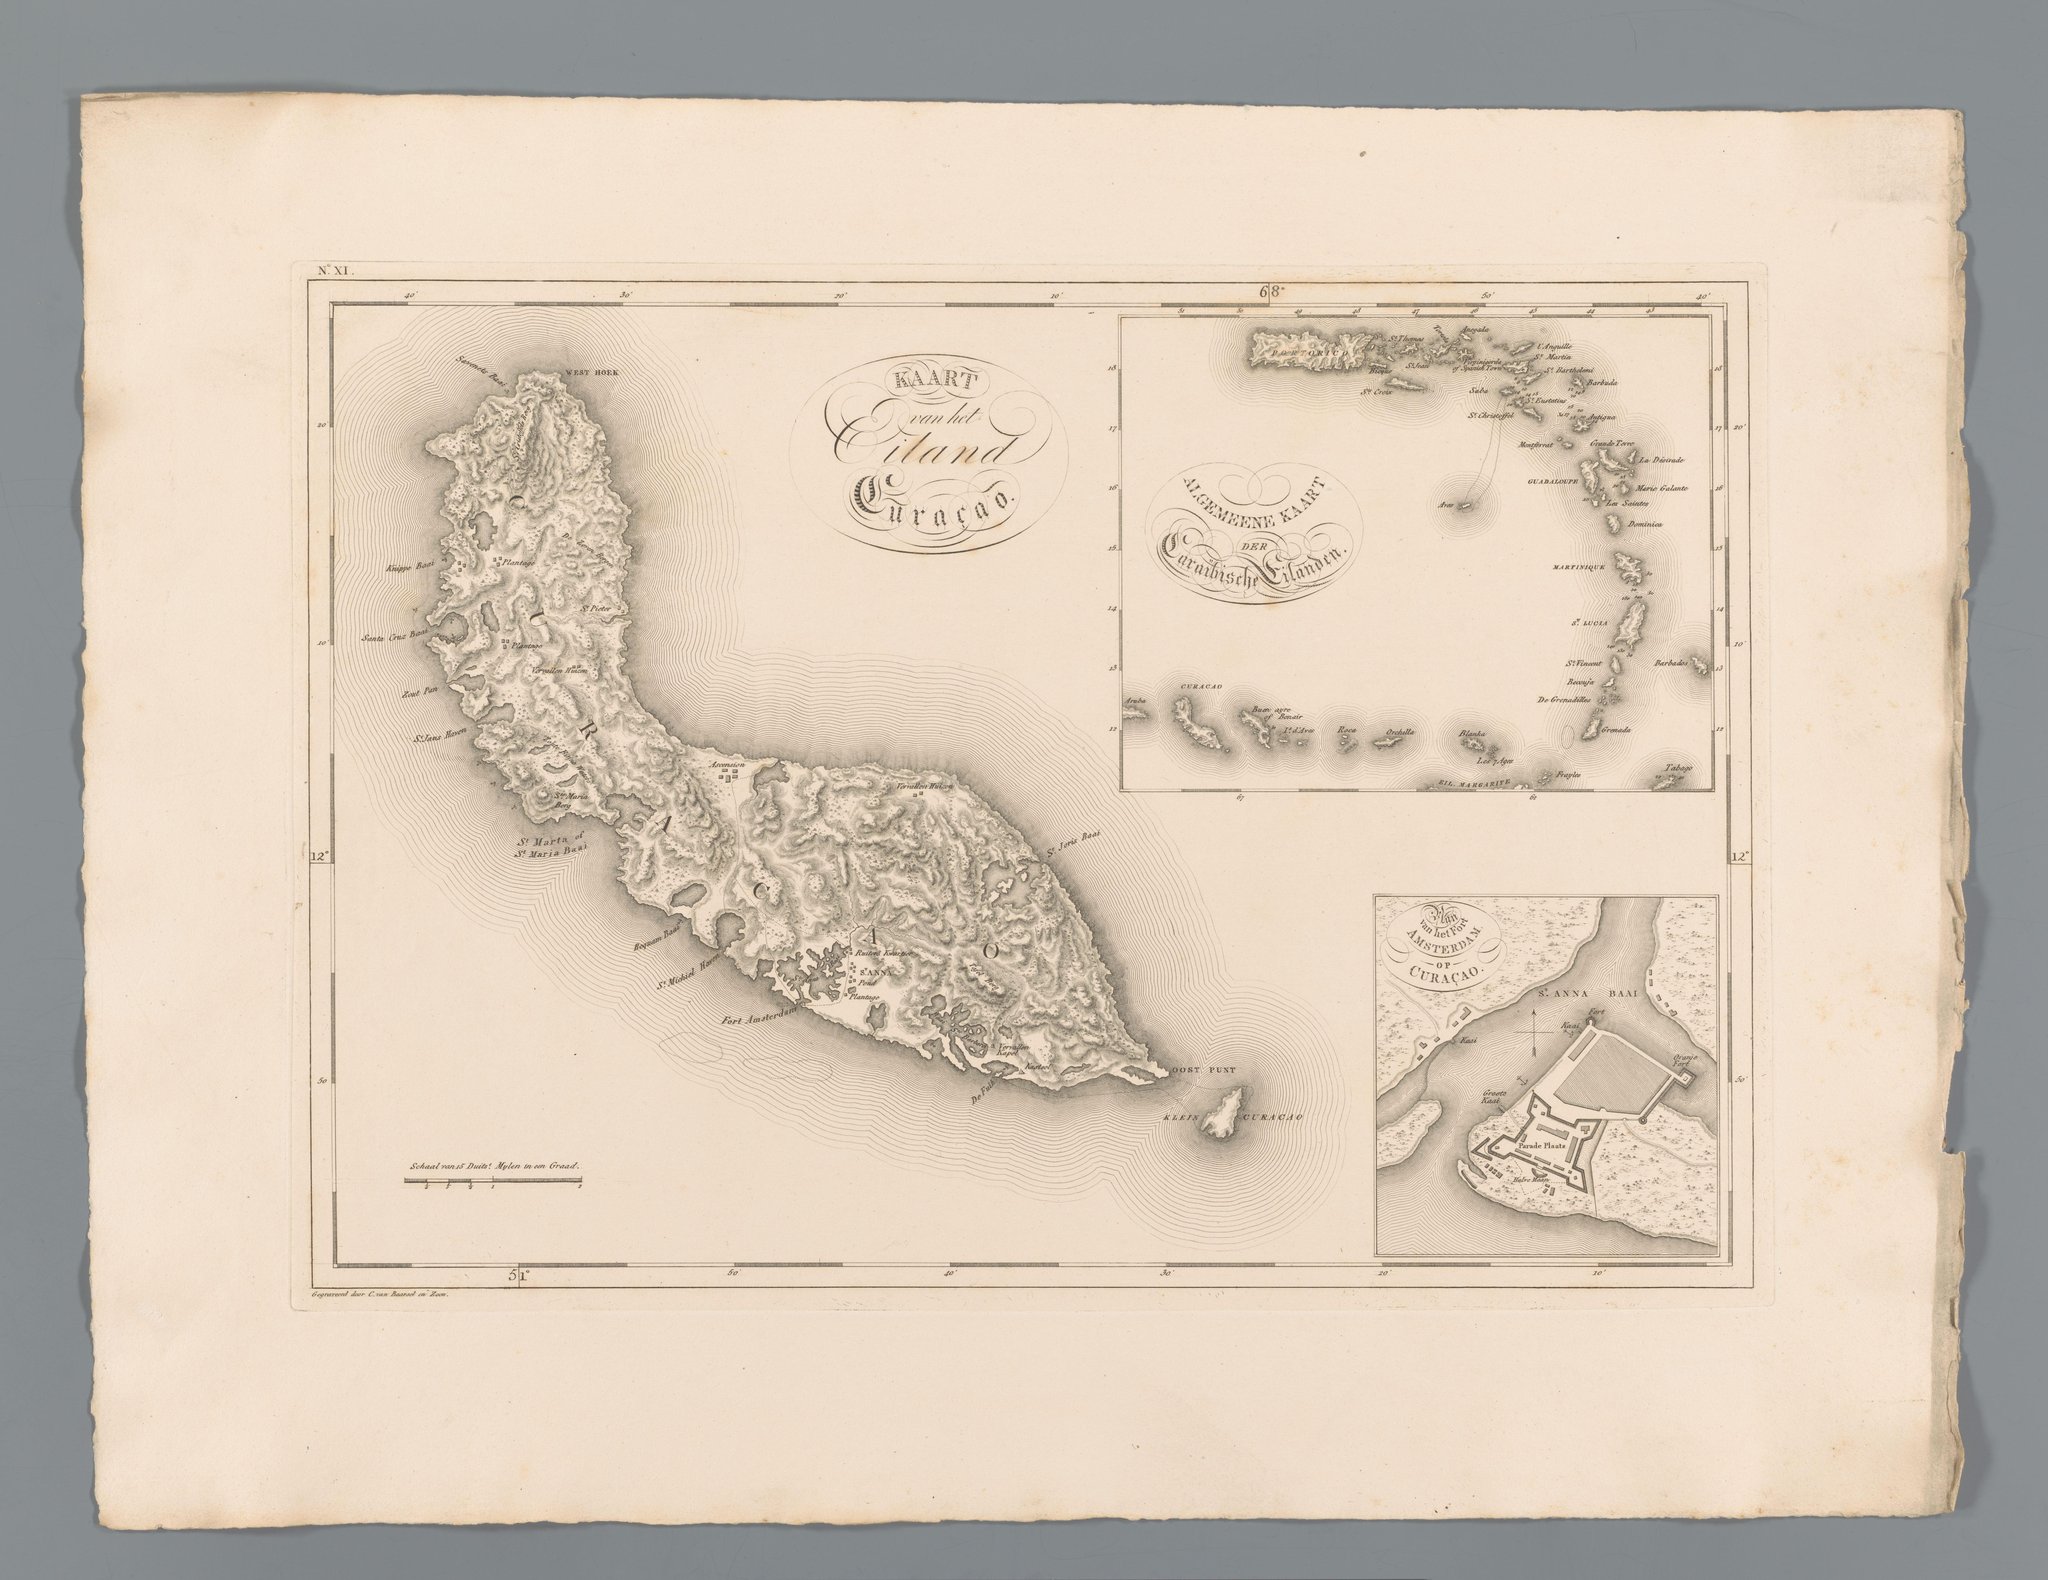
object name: print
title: Plan van het fort Amsterdam op Curaçao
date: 1818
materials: paper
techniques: engraving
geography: the hague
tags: maps of separate countries or regions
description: Kaart uit: Bosch, Js. van den. Atlas der overzeesche bezittingen van Zijne Majesteit den Koning der Nederlanden, aan hoogst denzelven opgedragen. Den Haag en Amsterdam: Gebroeders van Cleef, 1818.